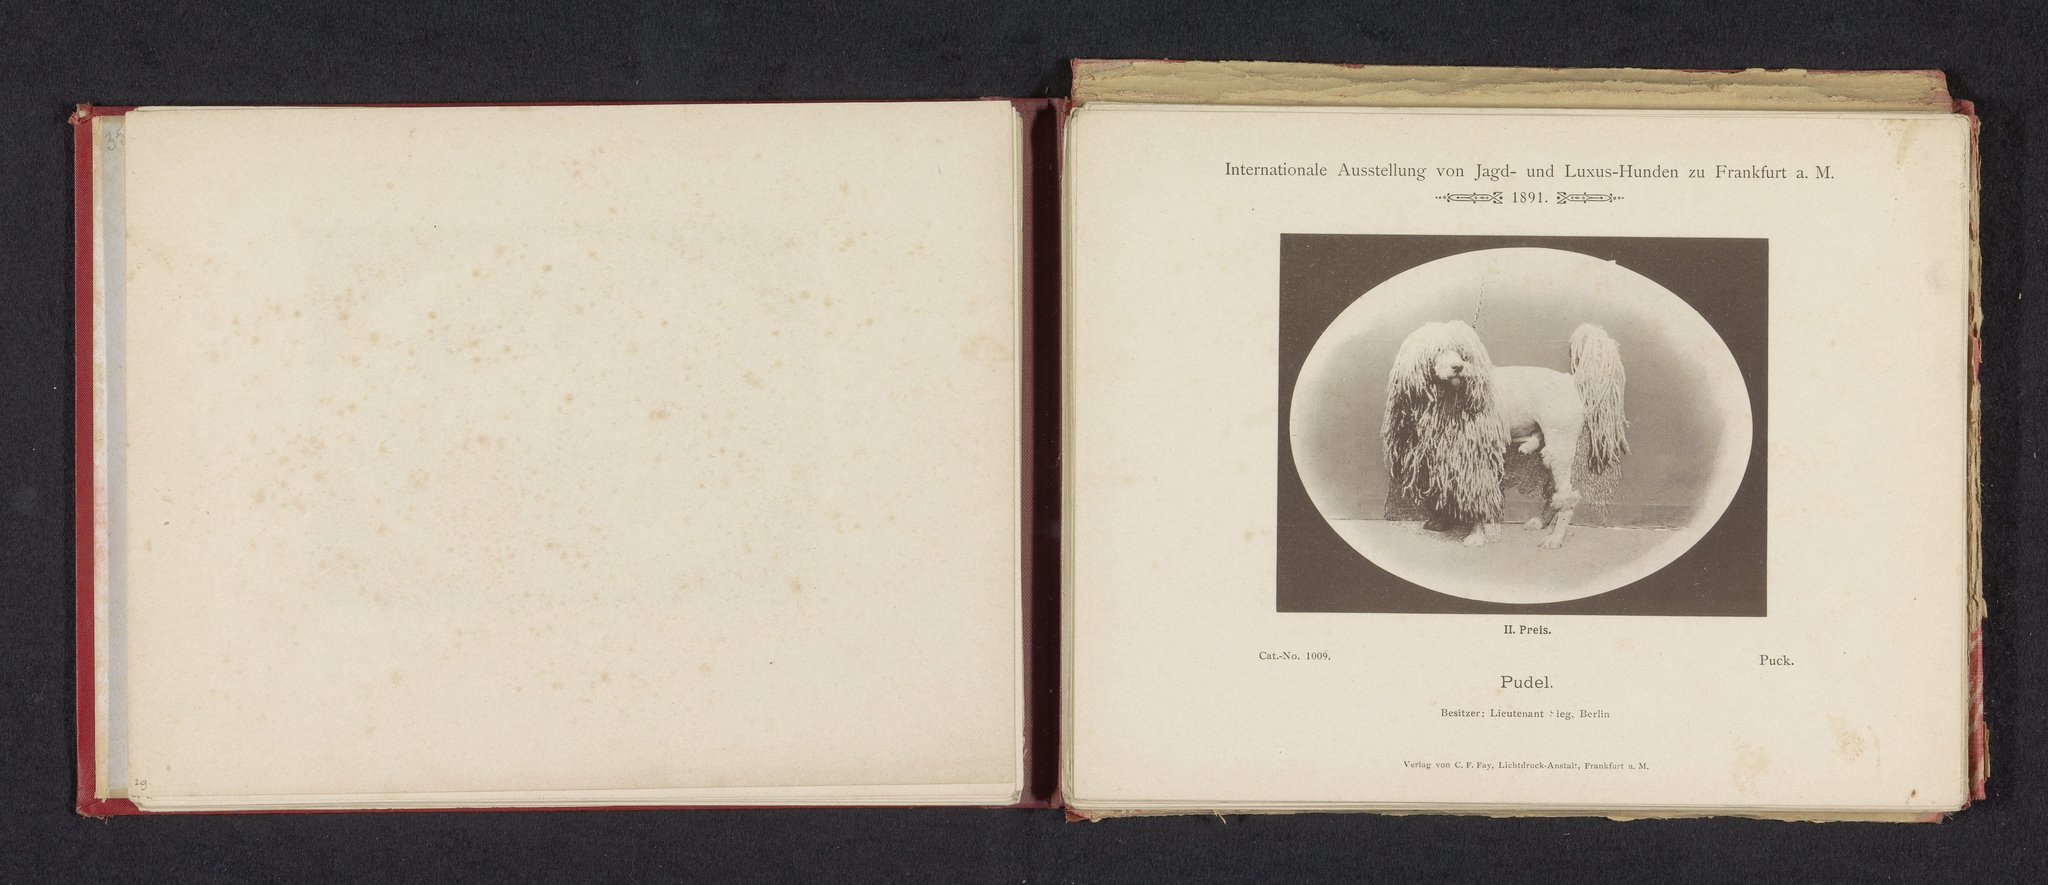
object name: page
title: Poedel Puck die een tweede prijs heeft gewonnen op de Internationale Ausstellung von Jagd und Luxus Hunden in 1891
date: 1891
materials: paper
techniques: photograph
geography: frankfurt am main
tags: dog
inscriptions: inscription: ‘II. Preis. Puck. Besitzer : Lieutenant Sieg, Berlin’, number: ‘Cat.-No. 1009.’